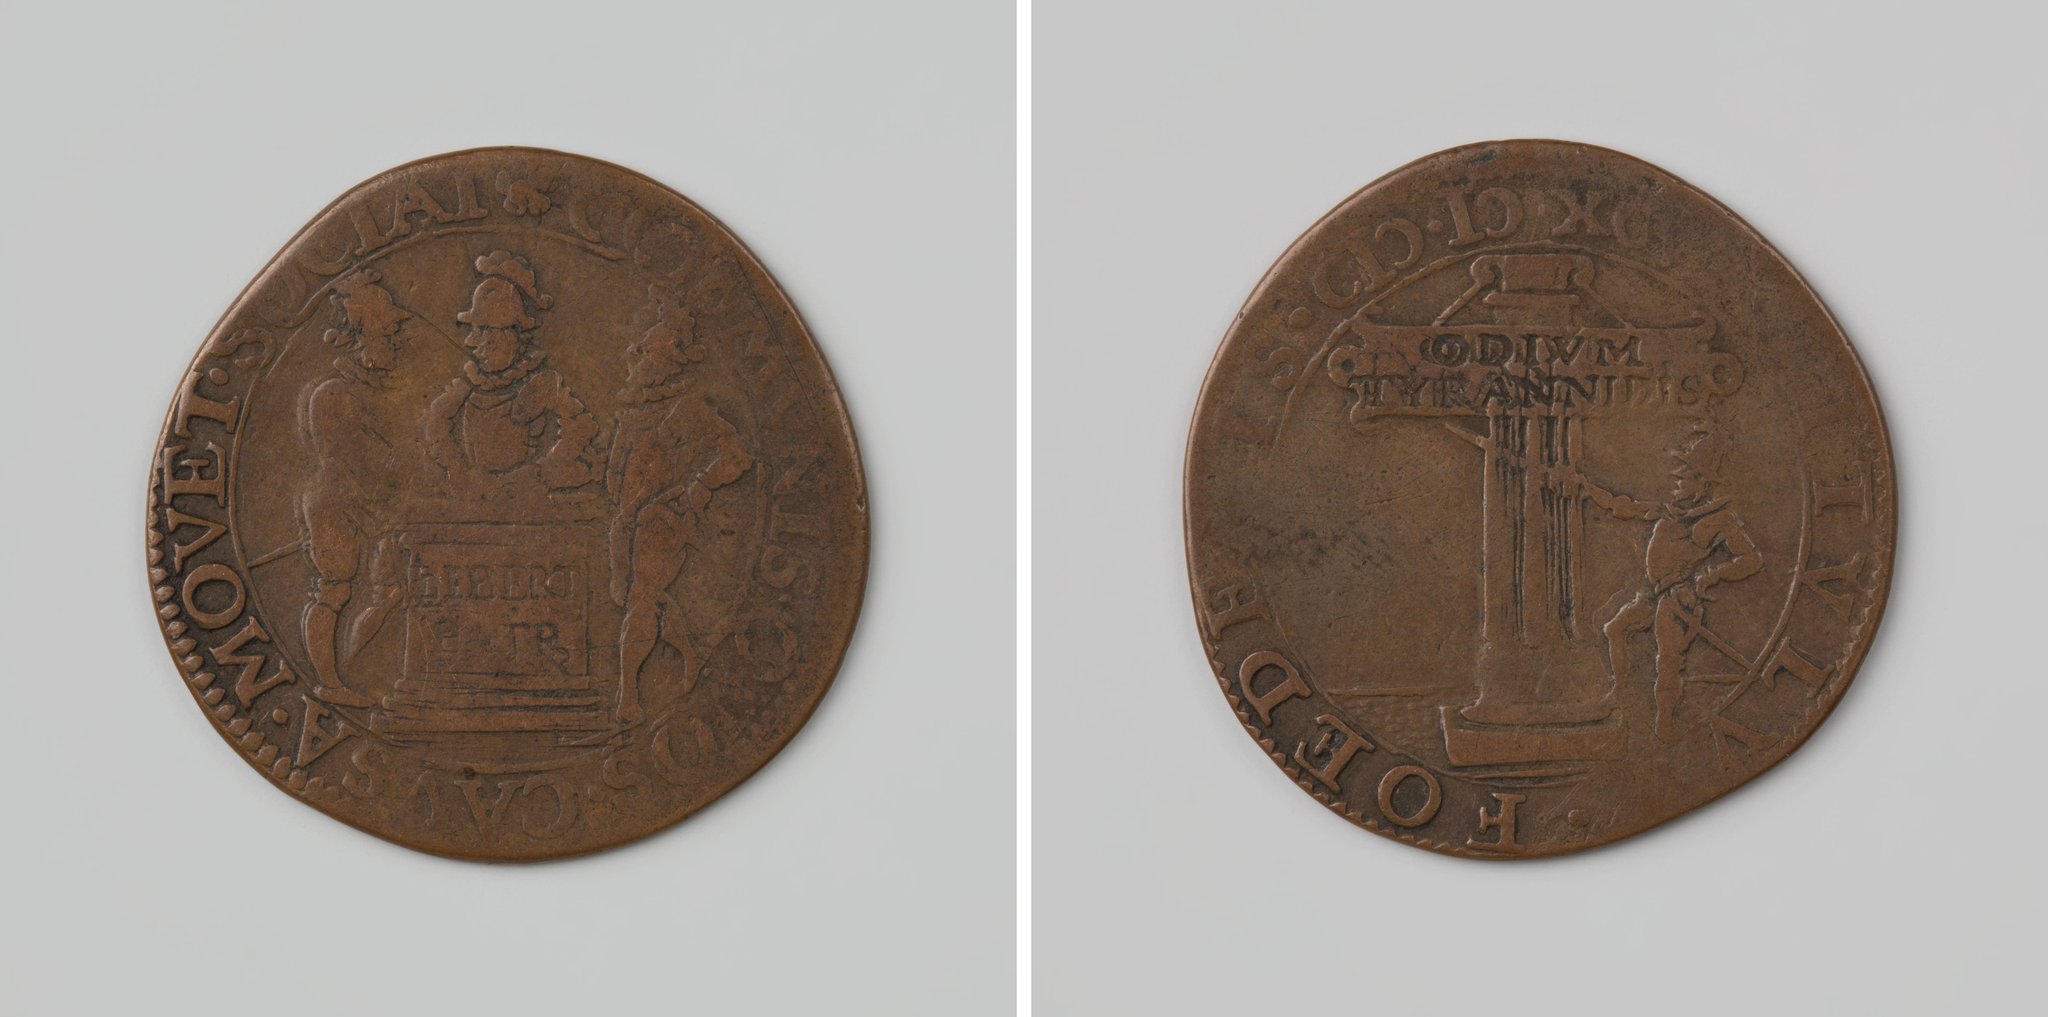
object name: jeton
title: Sluiting van het drievoudige verbond tussen Engeland, Frankrijk en de Republiek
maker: Anonymous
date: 1596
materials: copper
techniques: striking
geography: dordrecht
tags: netherlands, france, england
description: Koperen penning. Voorzijde: drie soldaten, voorstellende de drie verdragspartners, staande rond altaar met opschrift binnen omschrift. Keerzijde: soldaat, wijzend met stok op bord met opschrift, hangend aan zuil binnen omschrift.